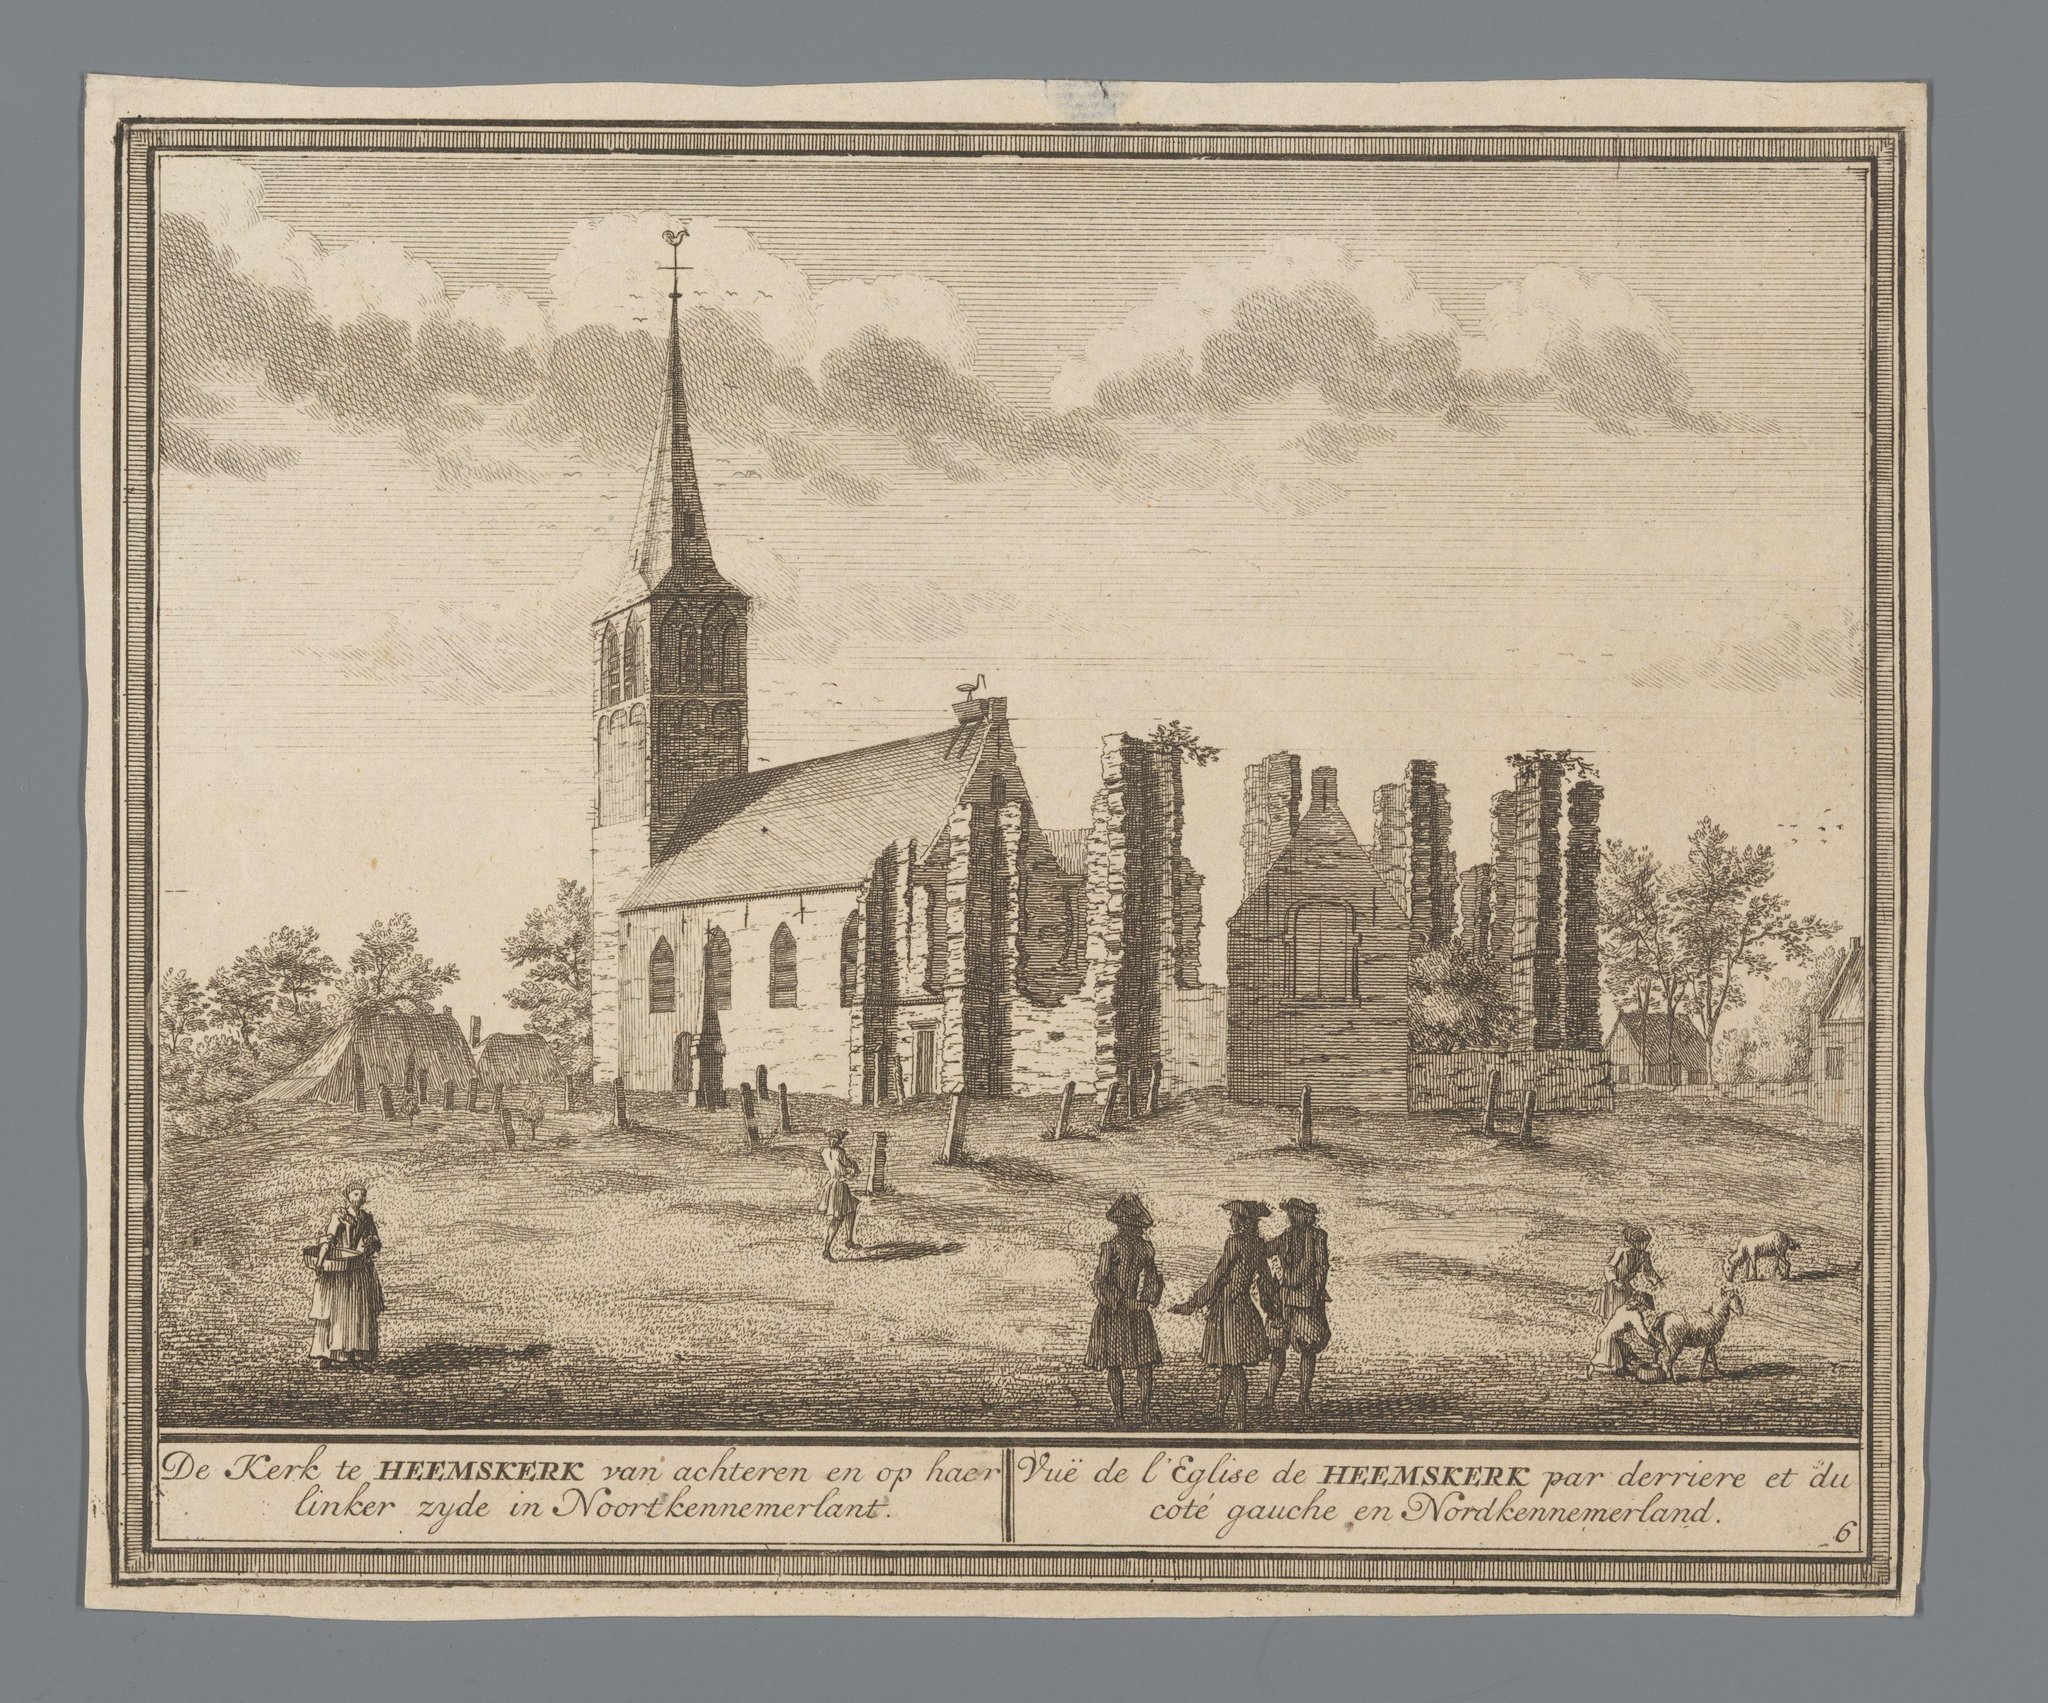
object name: print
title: Gezichten in Kennemerland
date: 1735-1742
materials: paper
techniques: etching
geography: amsterdam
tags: ruin of church, monastery, etc., landscape with ruins (+ city(-scape) with figures, staffage)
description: Prent uit: Leth, Hendrik de en Matthaeus Brouërius van Nidek. Het zegenpralend Kennemerland, vertoont in 100 heerelyke gezichten (...). Amsterdam: Jan Roman, [ca. 1735-1742].